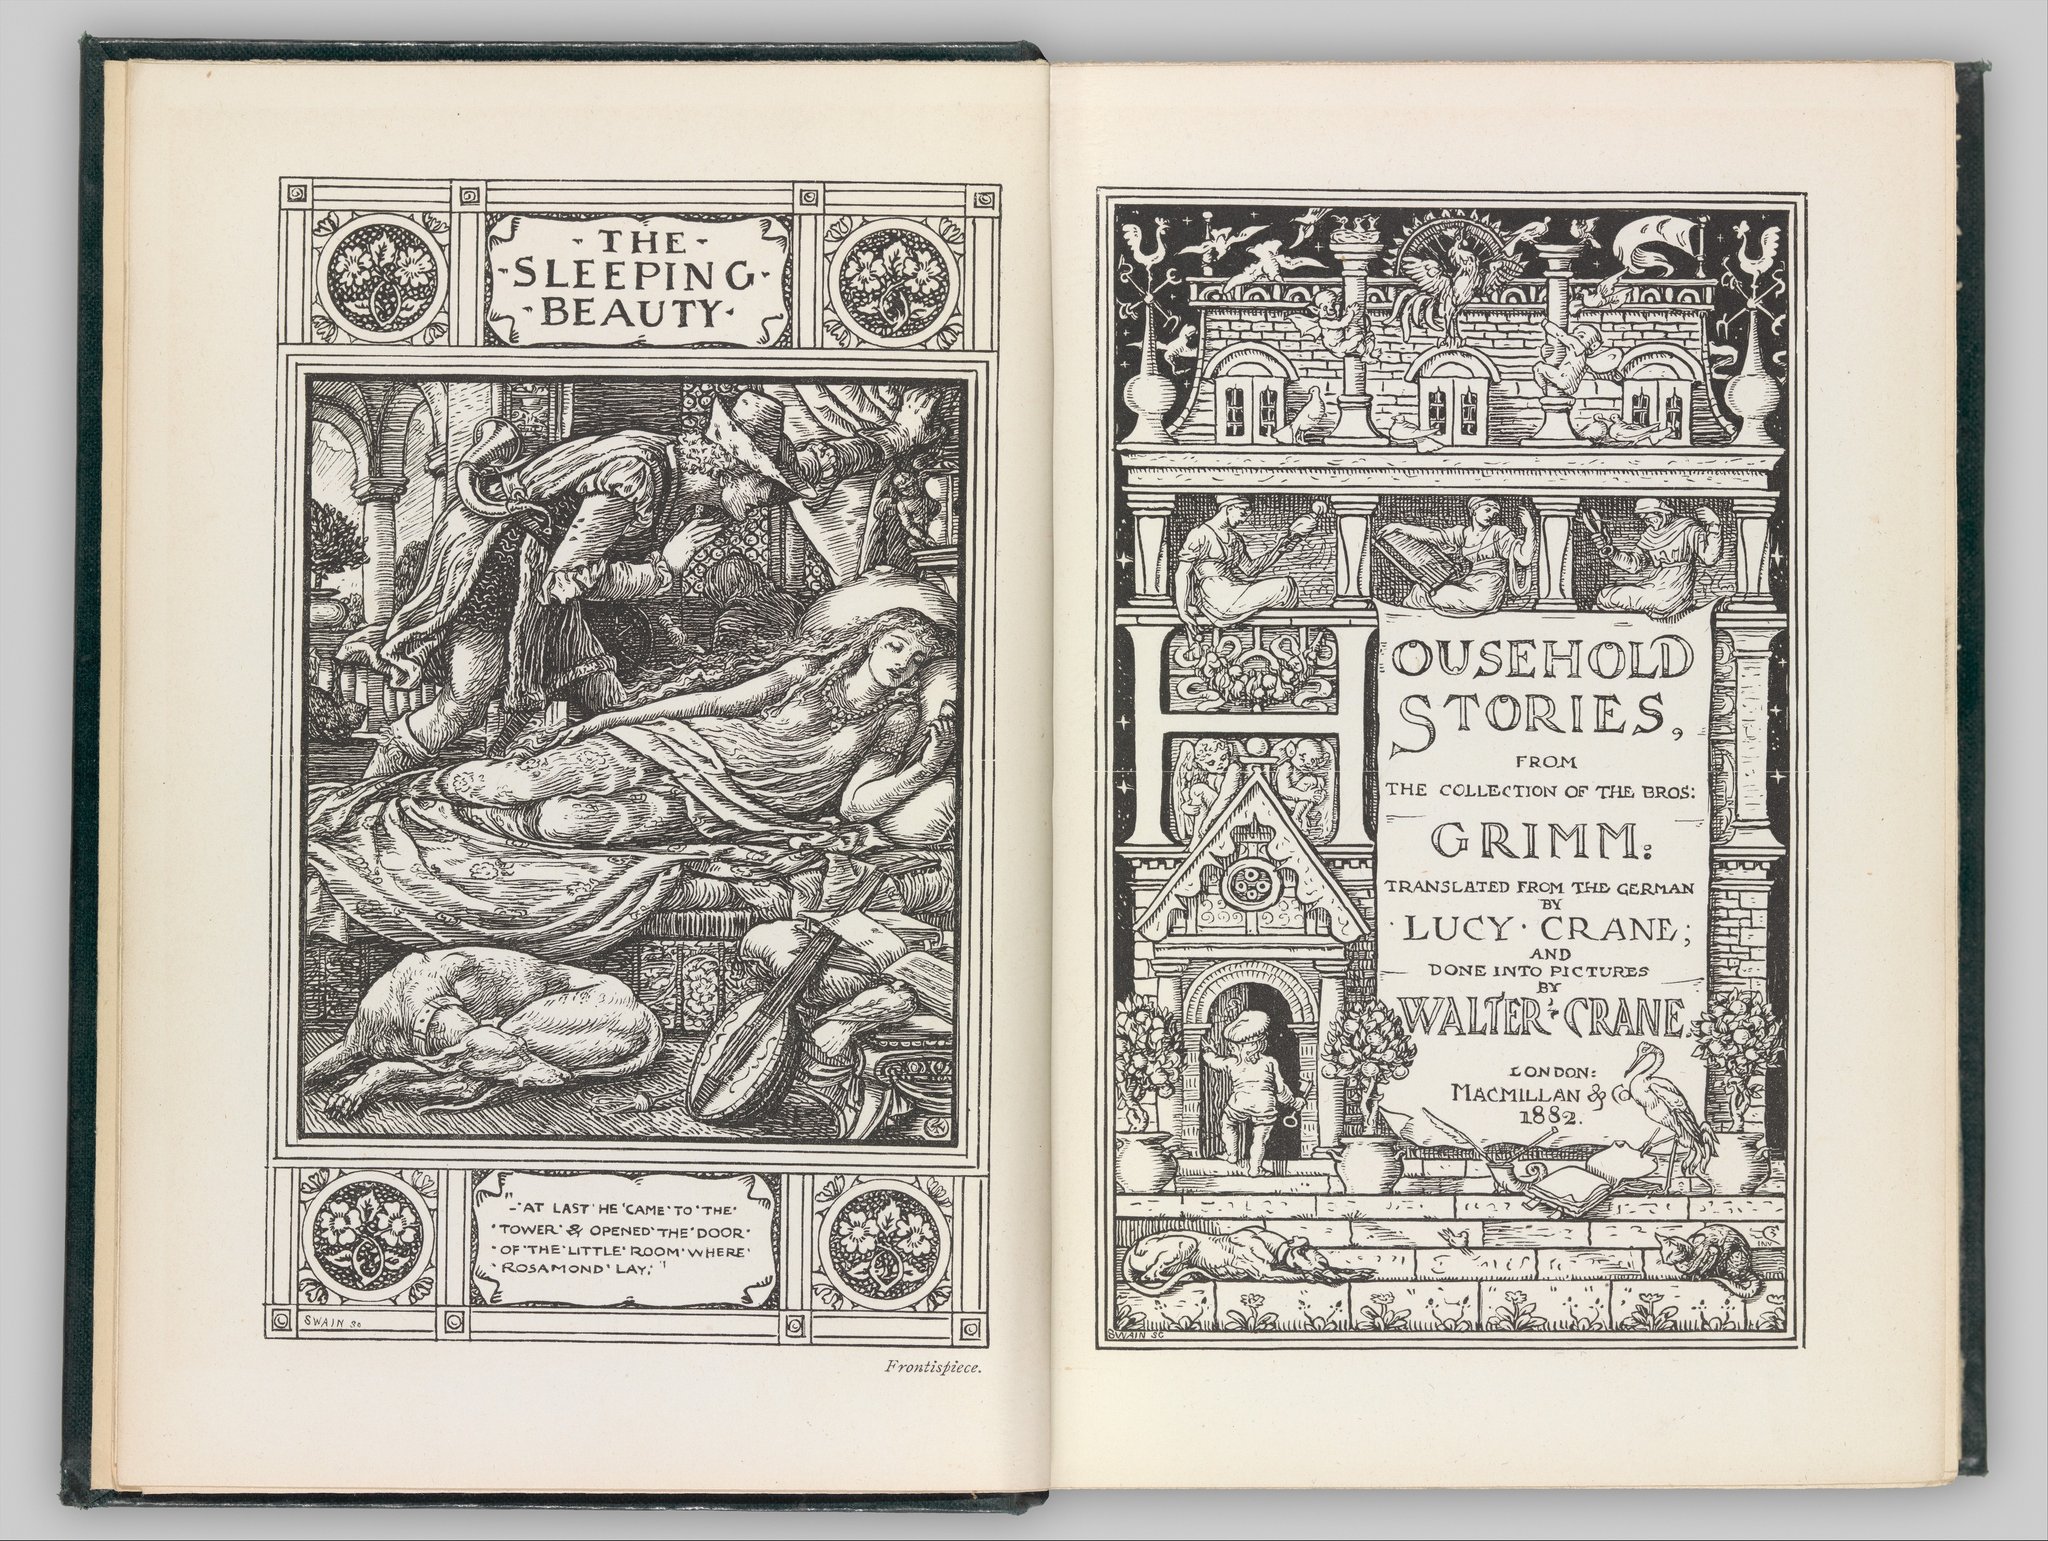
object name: book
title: Household Stories from the Collection of the Brothers Grimm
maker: jacob ludwig carl grimm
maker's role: author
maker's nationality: german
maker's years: 1785-1863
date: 1882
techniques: engraving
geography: england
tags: cranes,sleeping,men,women,lutes,cats,dogs,flowers,allegory